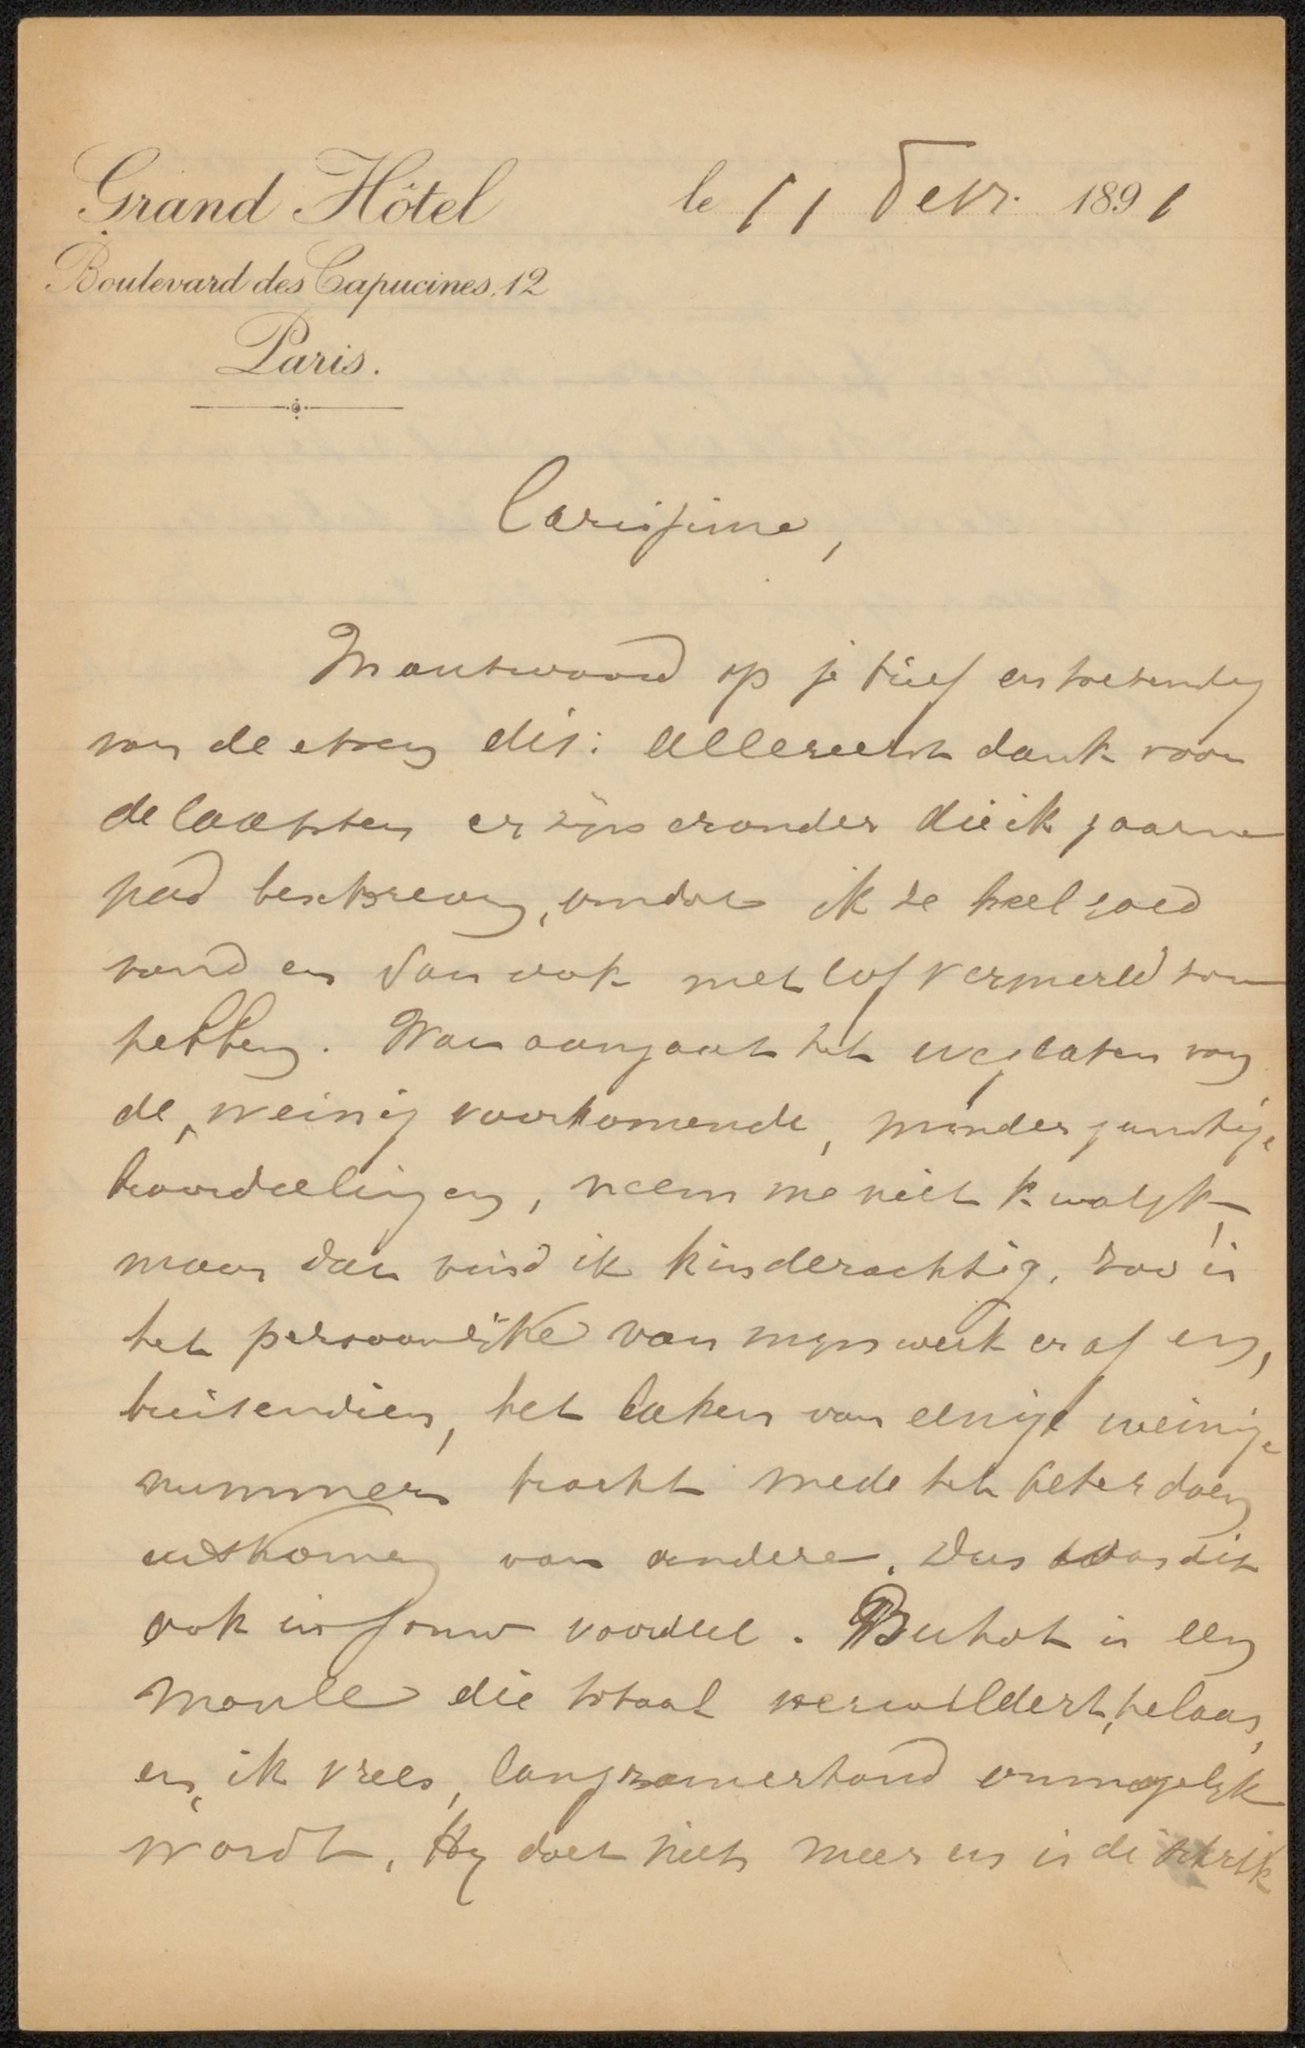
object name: letter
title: Brief aan Philip Zilcken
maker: adriaan pit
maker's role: print maker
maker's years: 1860-1944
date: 1891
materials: ink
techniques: pen, printing, writing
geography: paris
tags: françois courboin, paris, félix hilaire buhot, brussels, politician, jules destrée, lev tolstoj, painter, draughtsman, philip zilcken, the graphic arts, art collecting, printed matter, the hague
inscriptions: collector's mark: ‘RPK’